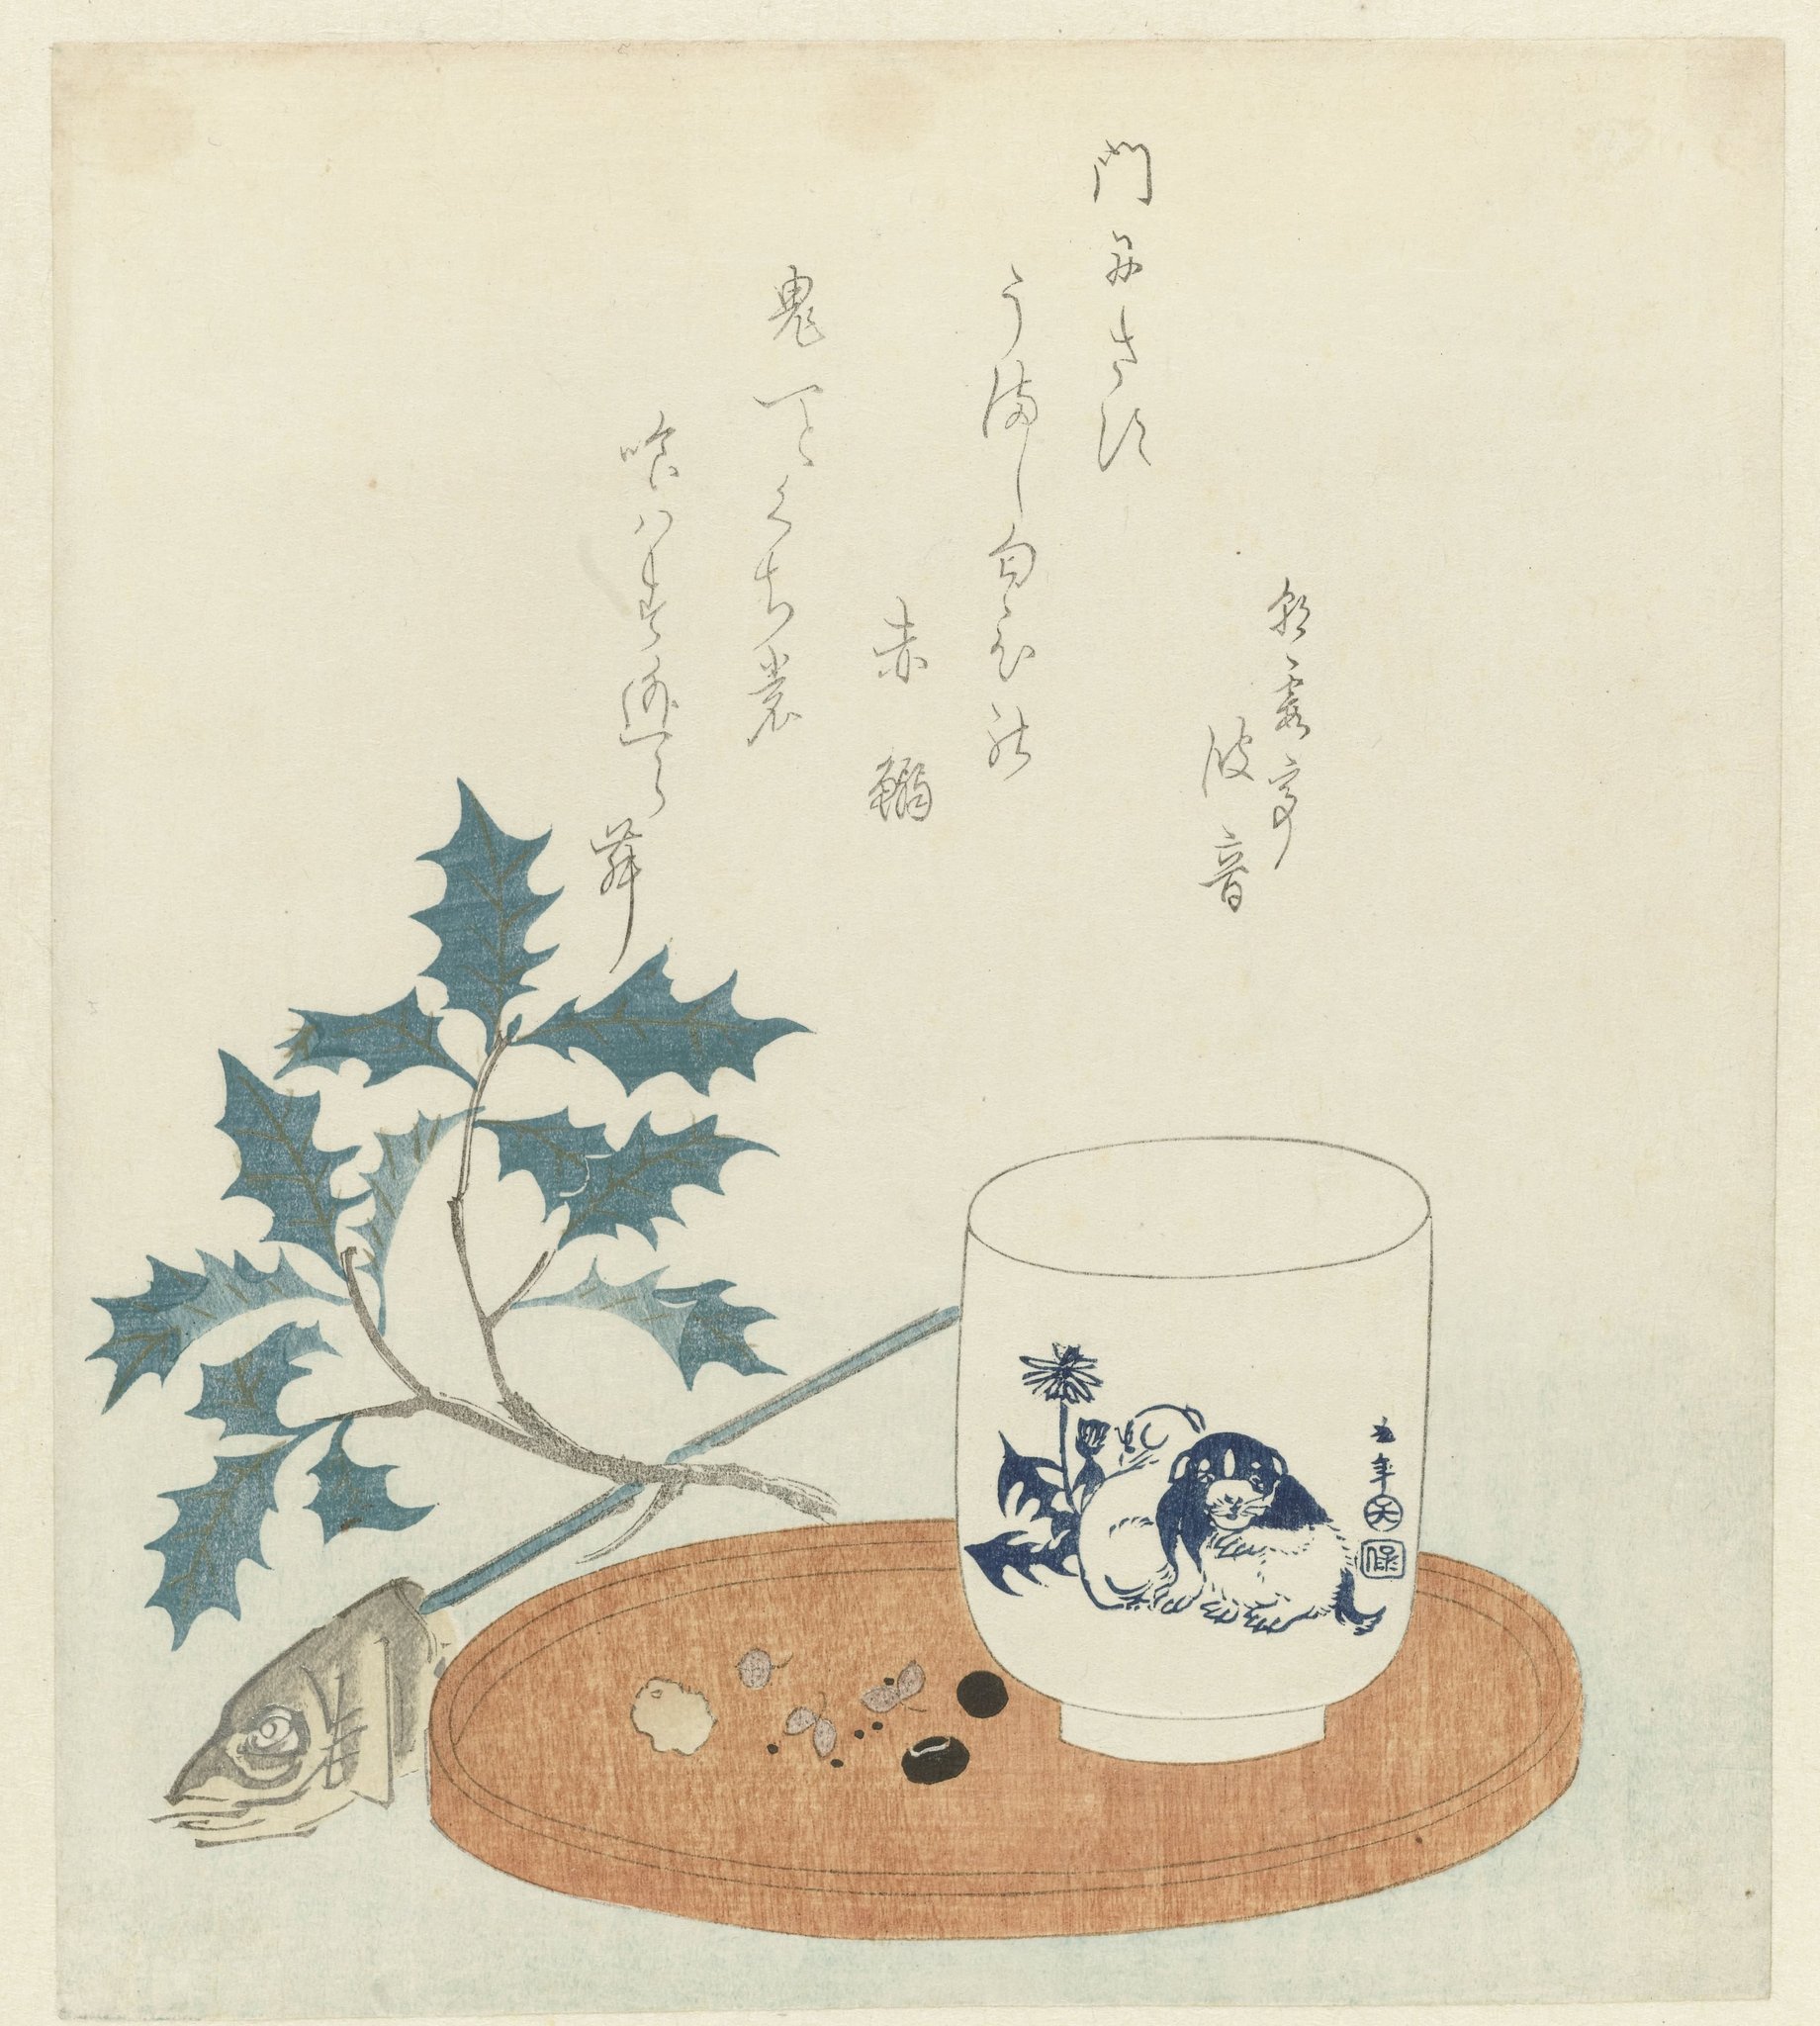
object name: surimono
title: Still Life for the New Year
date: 1838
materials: paper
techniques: blind stamped, woodcut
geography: japan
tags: plants and herbs: holly, drinking-vessels, still life of miscellaneous objects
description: Een porseleinen kopje waarop twee jonge hondjes en een paardebloem staan afgebeeld, staat op een dienblad van lakwerk. De zwarte bonen op het blad, dienen net als de hulsttak en de kop van de sardine, als afweer tegen het kwaad, zodat het nieuwe jaar zuiver kon beginnen en voorspoedig zou zijn. De hondjes verwijzen naar het nieuwe jaar van de Hond, 1838. Met één gedicht.